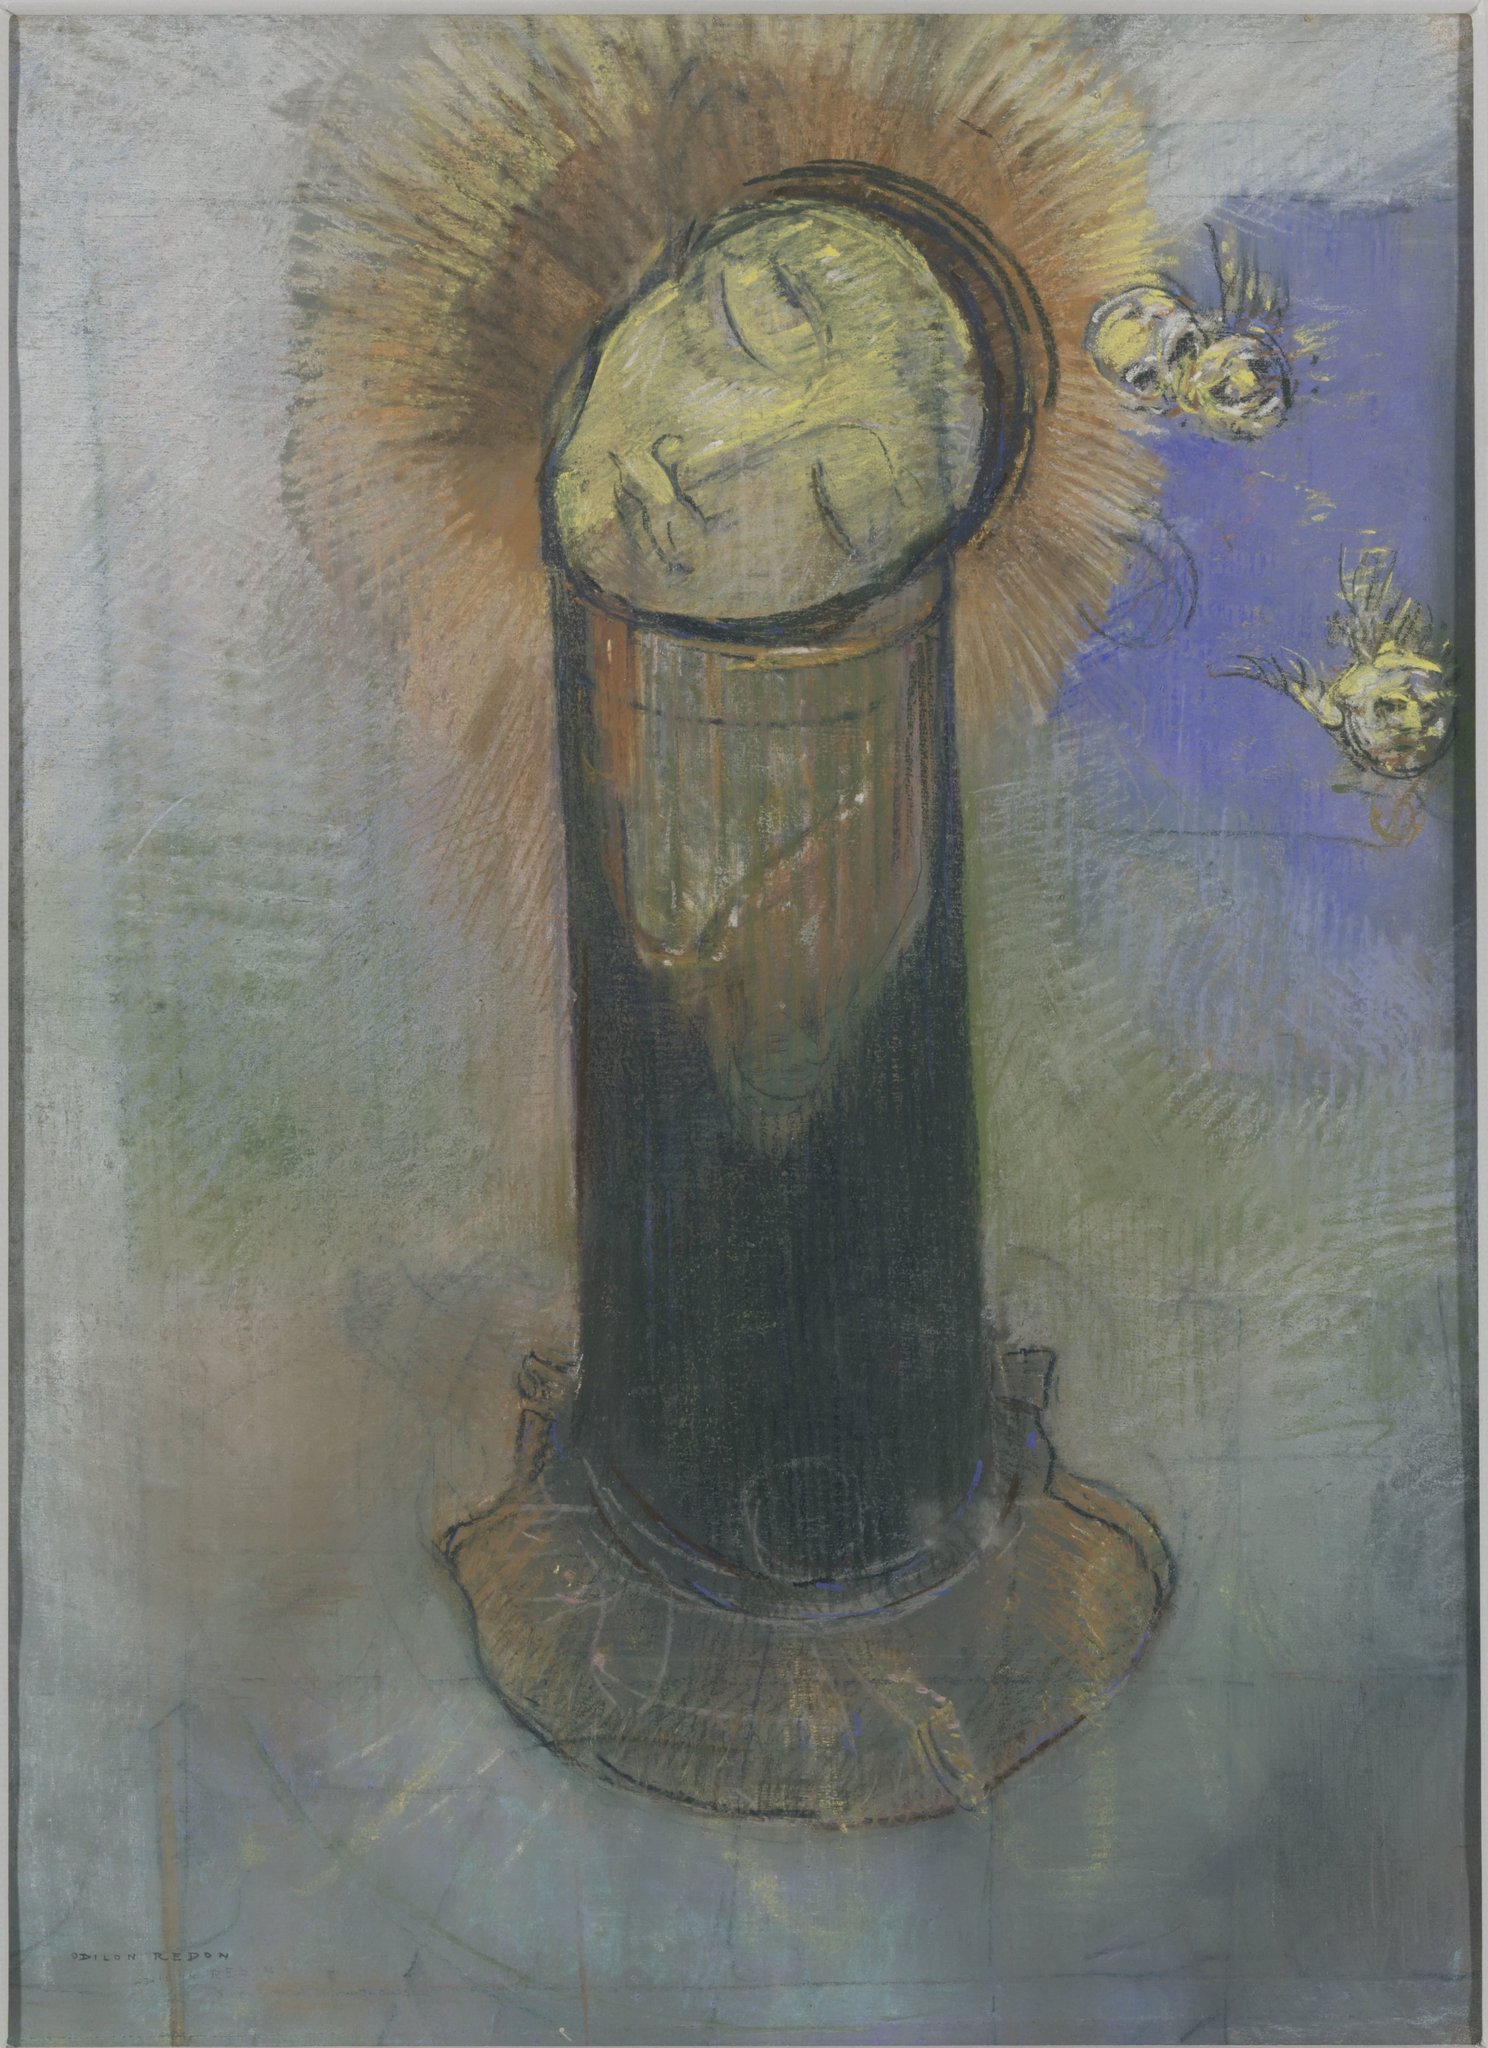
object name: drawing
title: Het hoofd van Johannes de Doper, op een pilaar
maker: odilon redon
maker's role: draughtsman, painter, print maker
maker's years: 1840-1916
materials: paper, pastel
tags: the head of john the baptist on a platter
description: Chandelle / De vlam vertoont een neigend hoofd/ La tête du decapité ou de S. Jean Baptiste